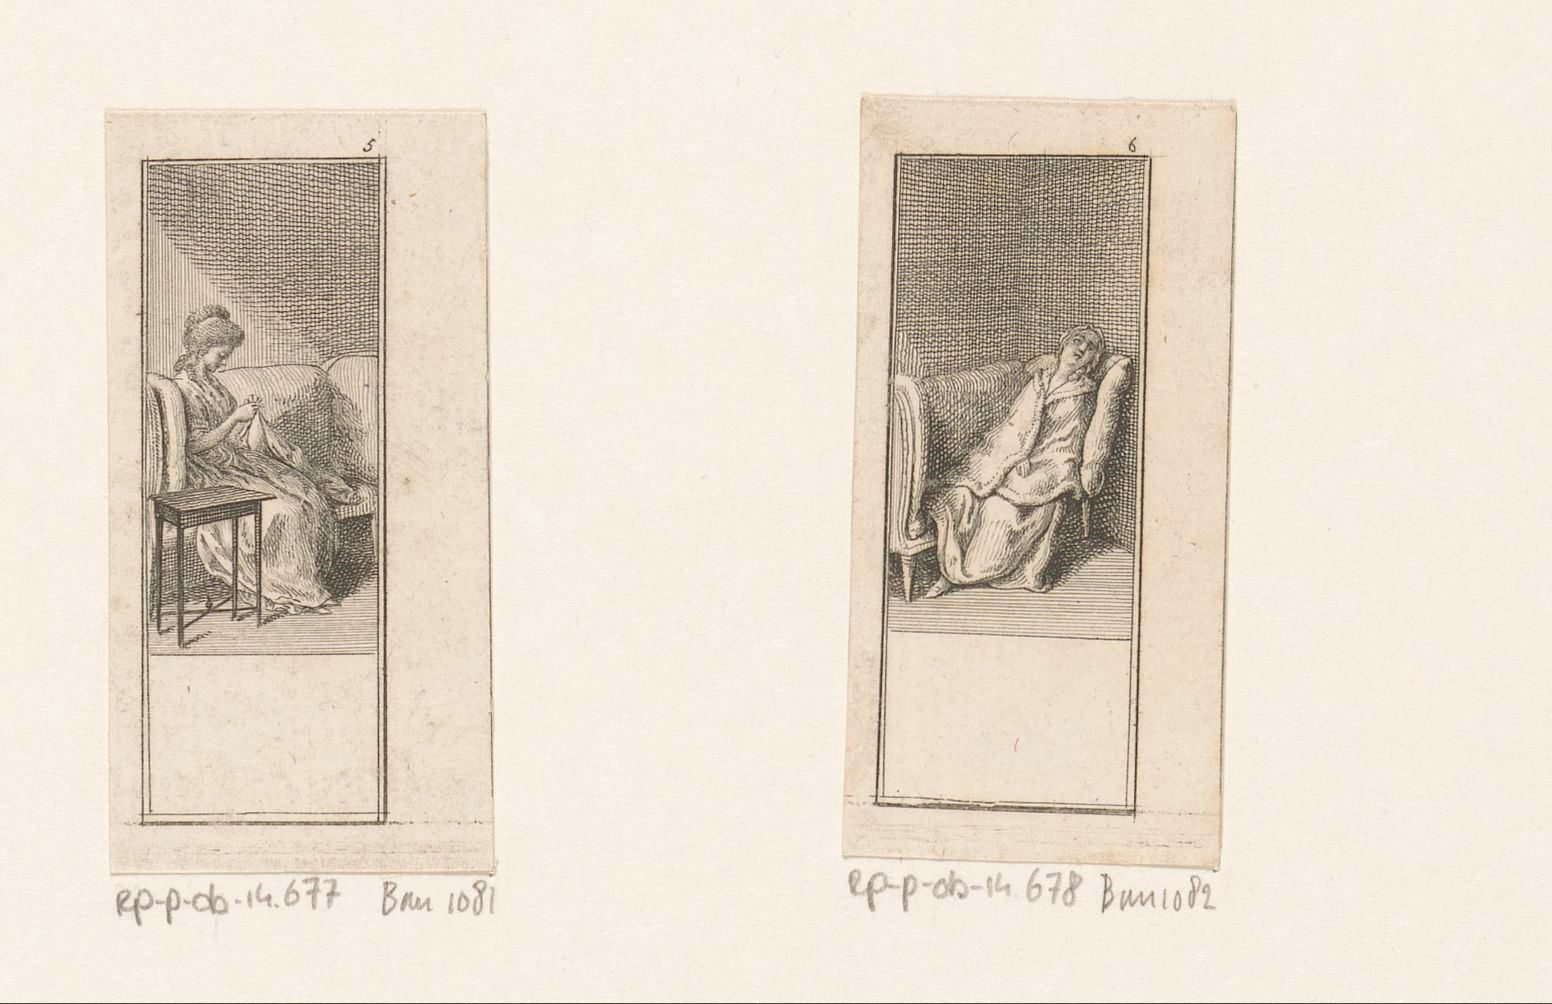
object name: print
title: Nijverheid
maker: daniel nikolaus chodowiecki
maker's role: draughtsman, print maker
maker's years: 1726-1801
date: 1784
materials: paper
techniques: etching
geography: berlin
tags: good and bad behaviour, moral qualities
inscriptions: collector's mark: Lugt 2228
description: Latere staat gebruikt voor: Kleinen Taschen Calender auf das gemeine Jahr 1785 (...). Berlijn: S.n., 1784.